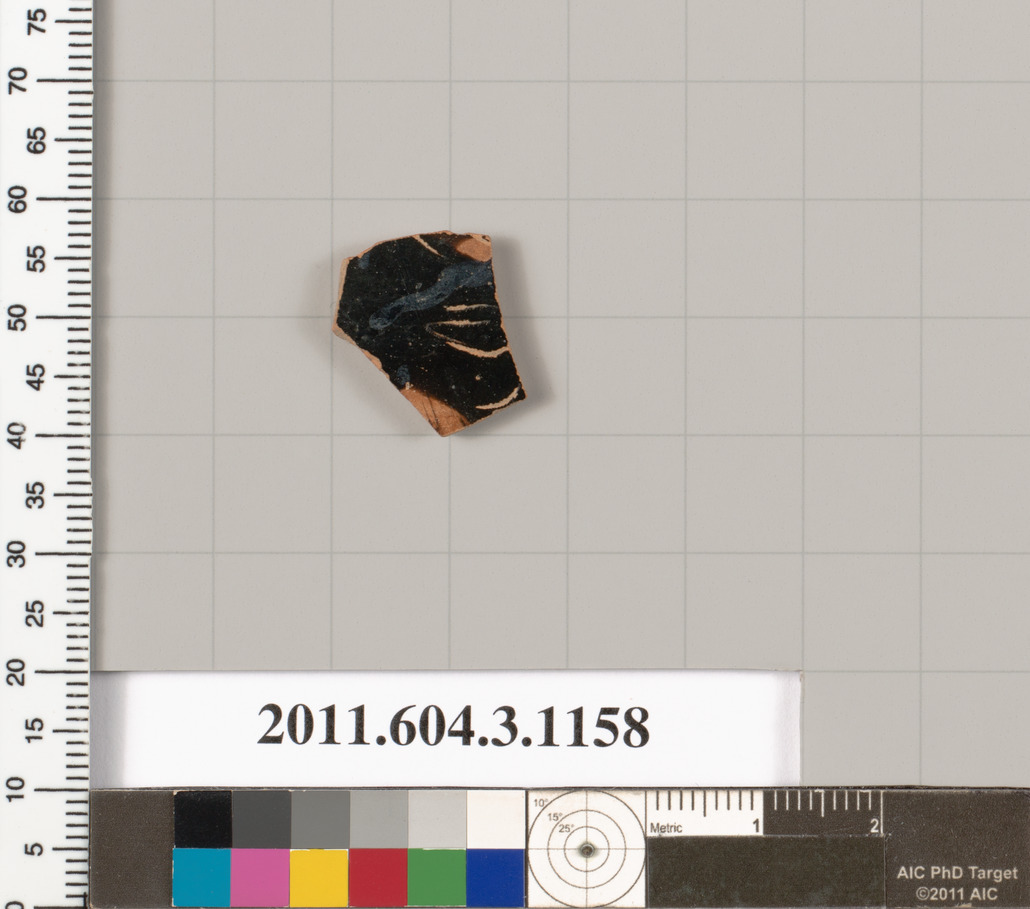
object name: mastoid or kyathos fragment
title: Terracotta fragment of a mastoid (drinking cup with narrow base) or a kyathos (cup-shaped ladle)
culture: greek, attic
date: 534-468 BCE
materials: terracotta